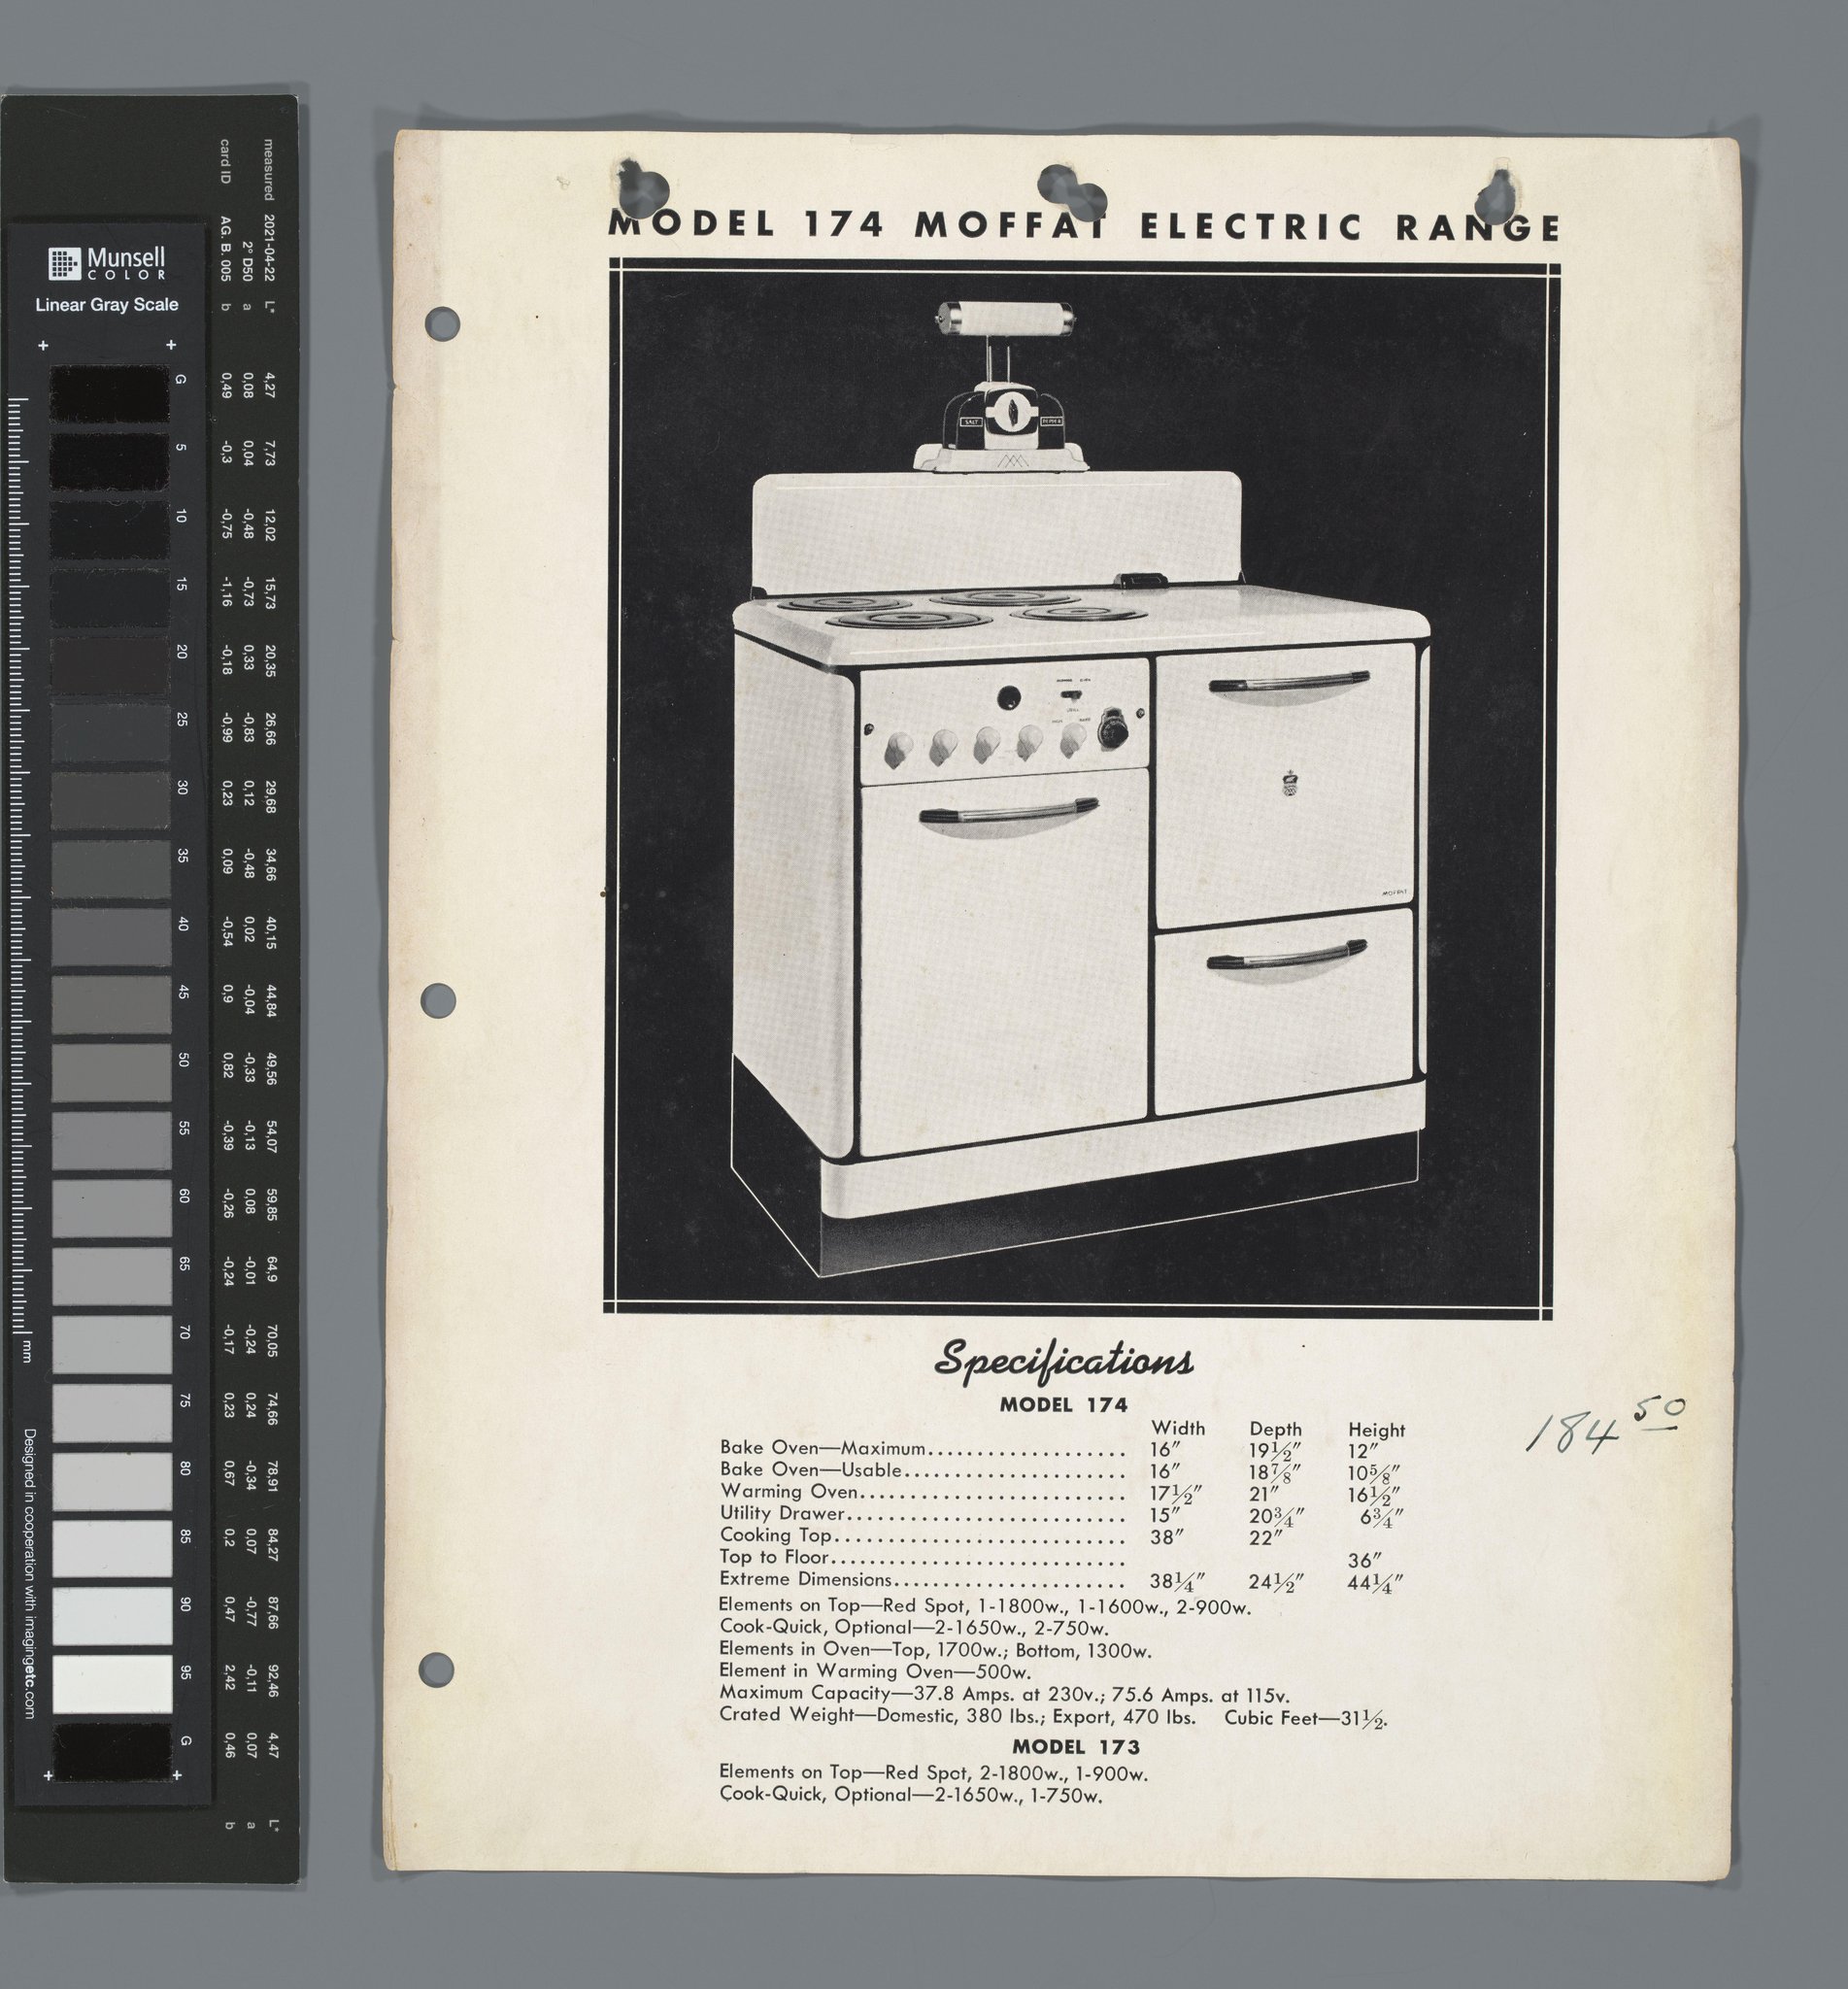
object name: photograph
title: Vel met gedrukte foto's van Moffat ovens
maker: Anonymous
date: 1935-1940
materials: paper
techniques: autotype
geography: canada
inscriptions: inscription: ‘18450’, inscription: ‘MODEL 174 MOFFAT ELECTRIC RANGE’